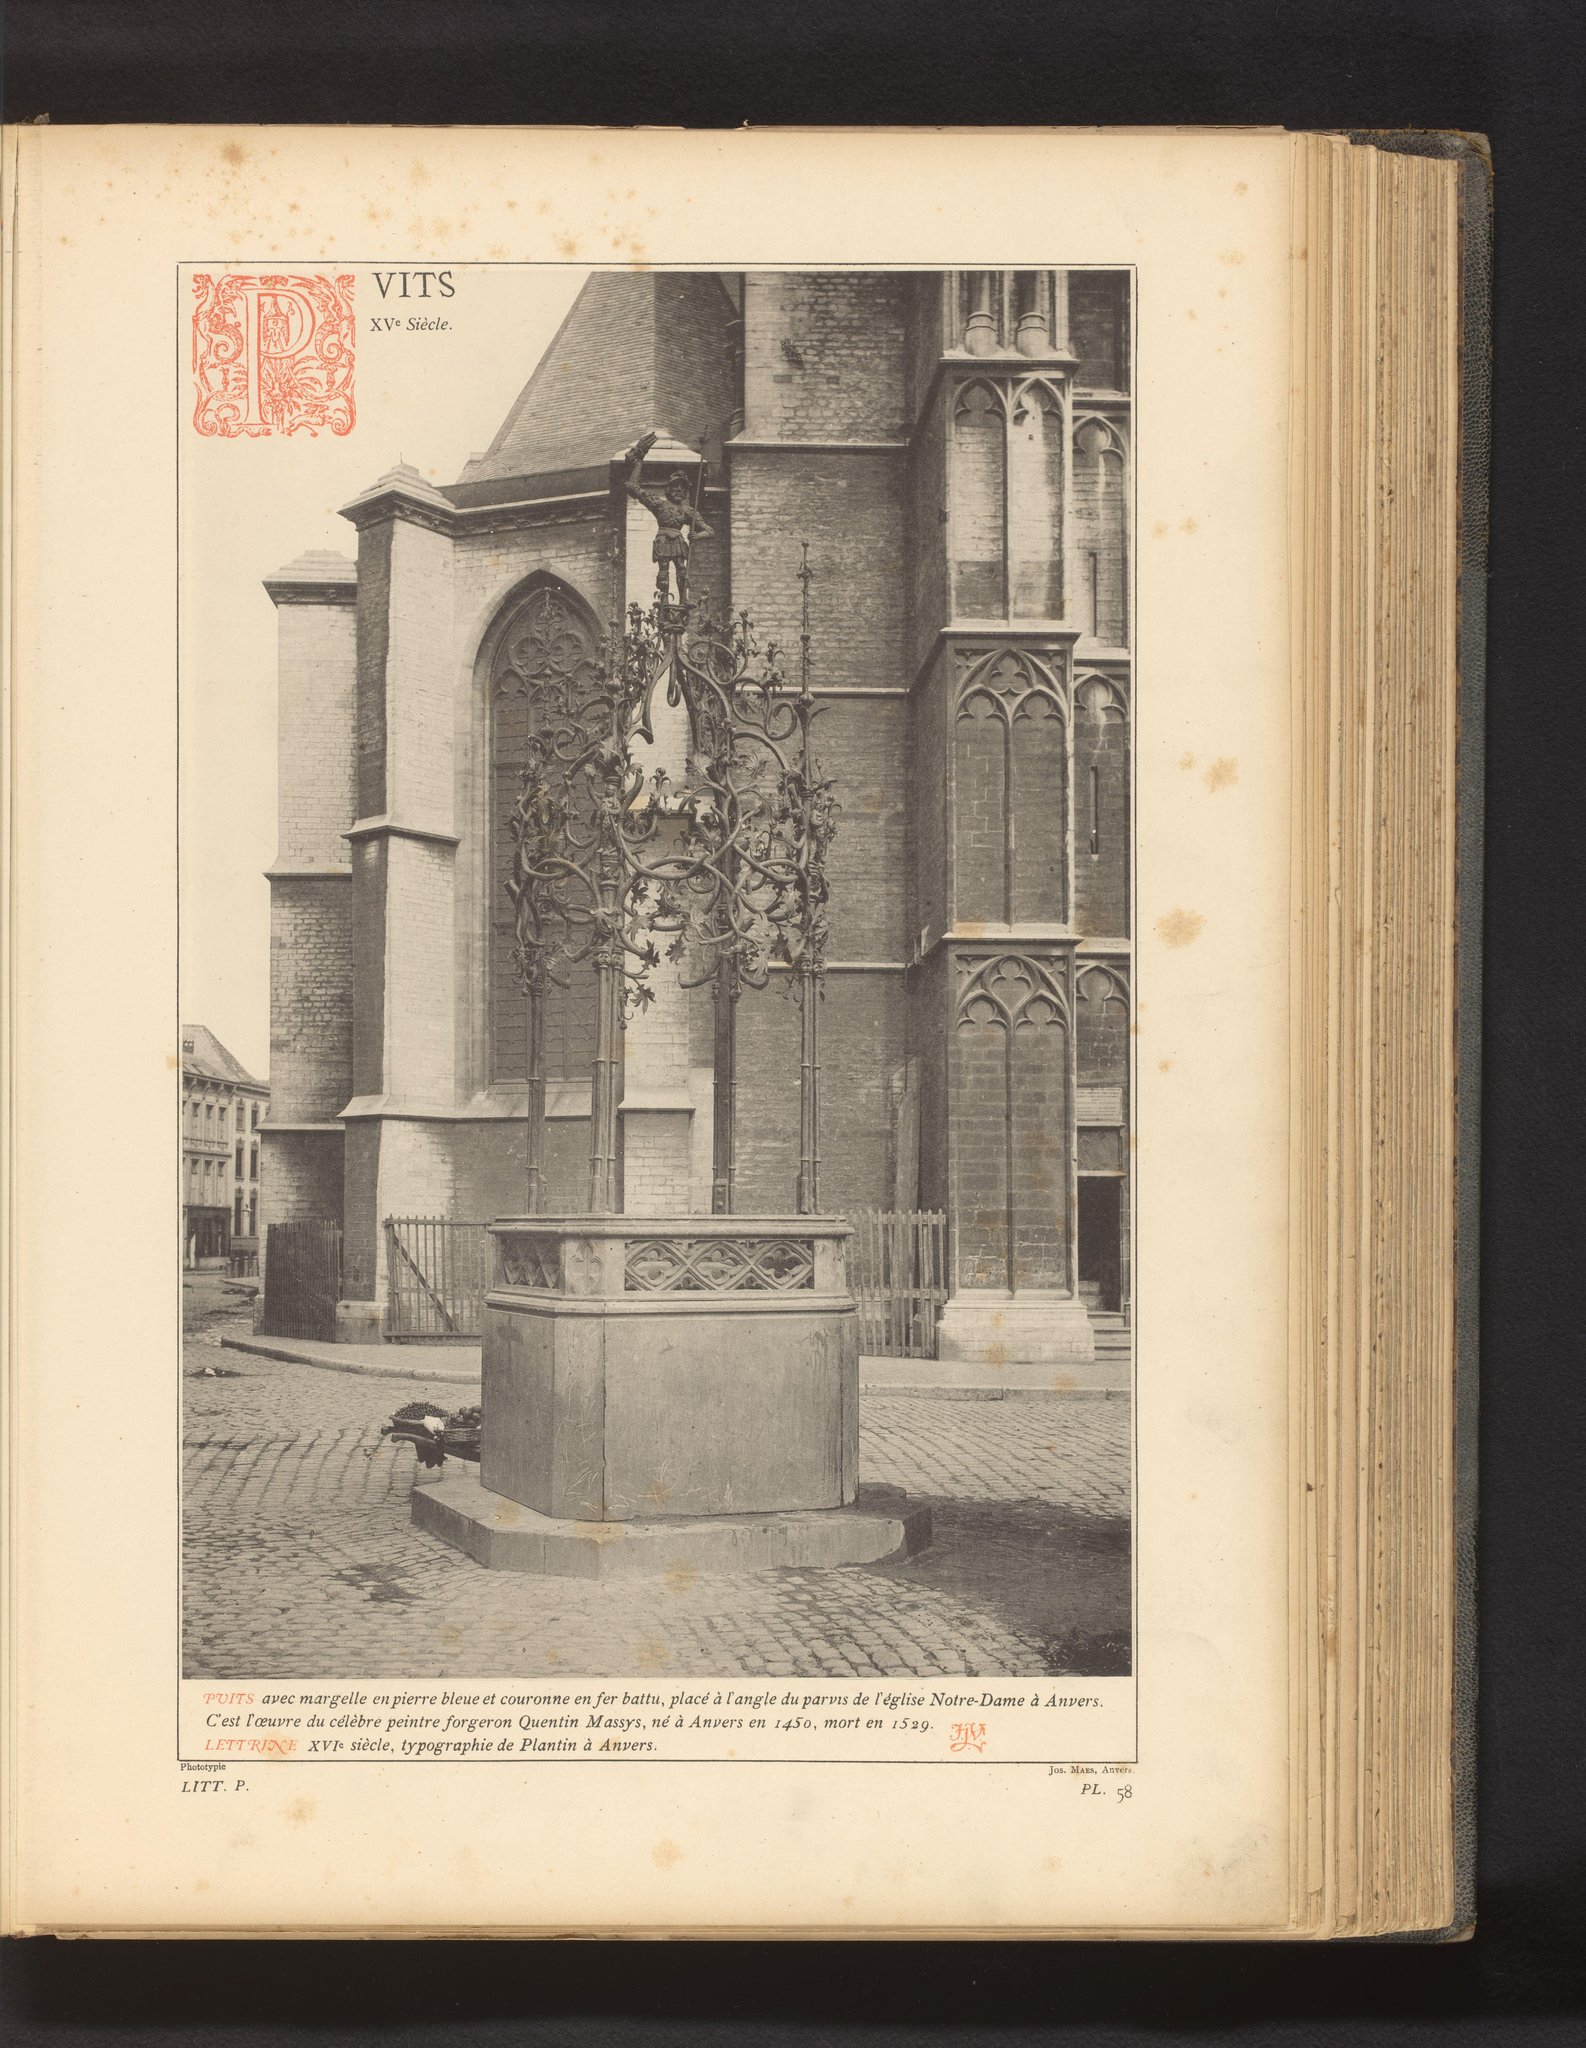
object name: page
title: Waterput bij de Onze-Lieve-Vrouwekathedraal te Antwerpen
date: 1876-1881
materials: paper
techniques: photograph, photolithography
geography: antwerp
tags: gate, entrance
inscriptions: monogram: ‘JJvY’, inscription: ‘PORTAIL principale d'une construction (...)’, inscription: ‘LITT. P. - PL. 32.’